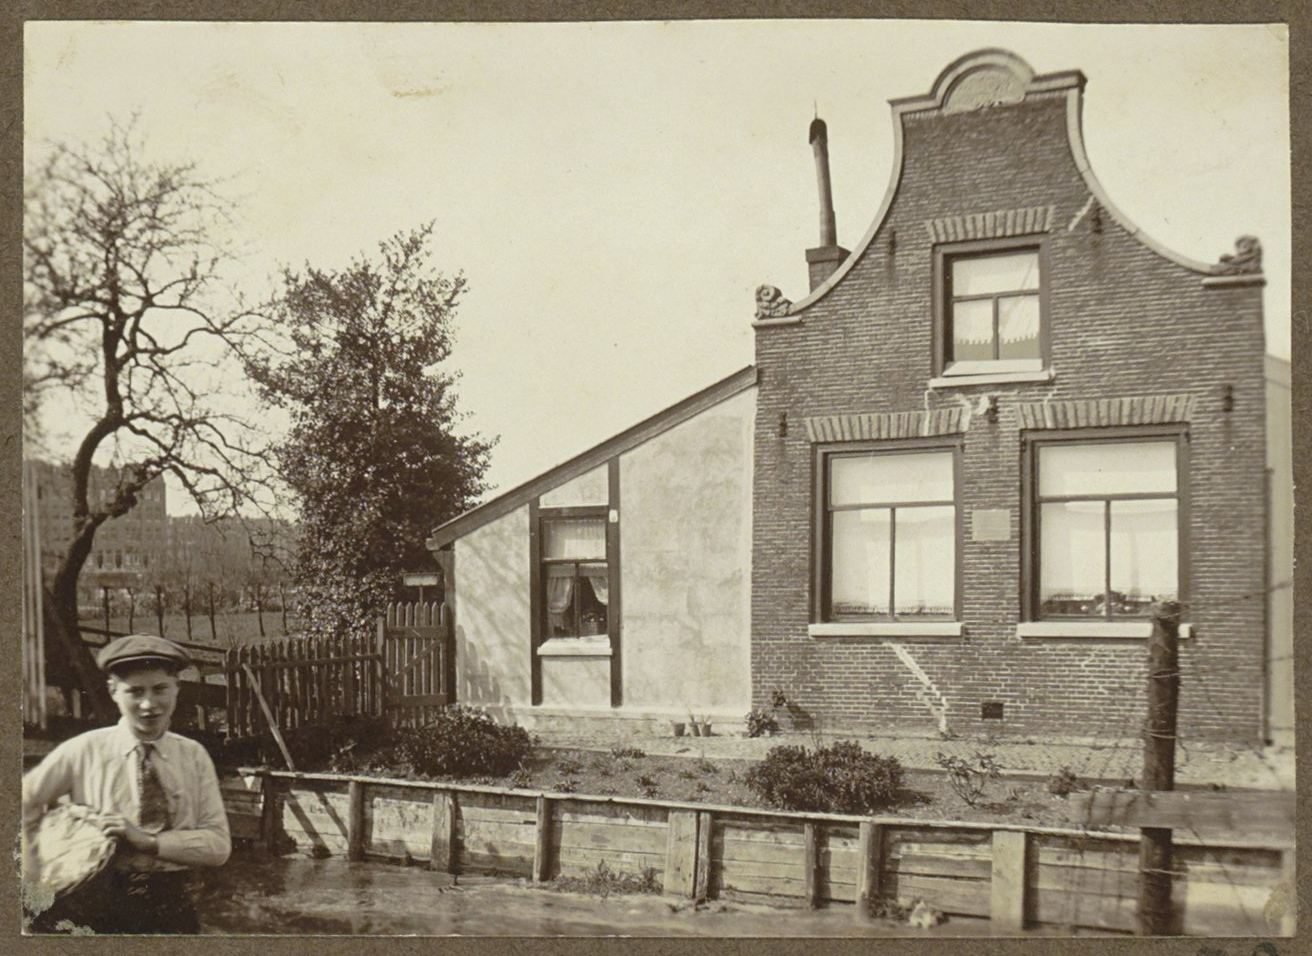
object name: photograph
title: Jongen voor een huis aan de Maljapenkade (De Wittenkade) te Amsterdam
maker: Anonymous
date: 1910-1930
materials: paper, photographic support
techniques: gelatin silver print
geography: amsterdam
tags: rural housing, e.g. country-house, villa, cottage, amsterdam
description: Onderdeel van Album met foto's van Amsterdam en omgeving.